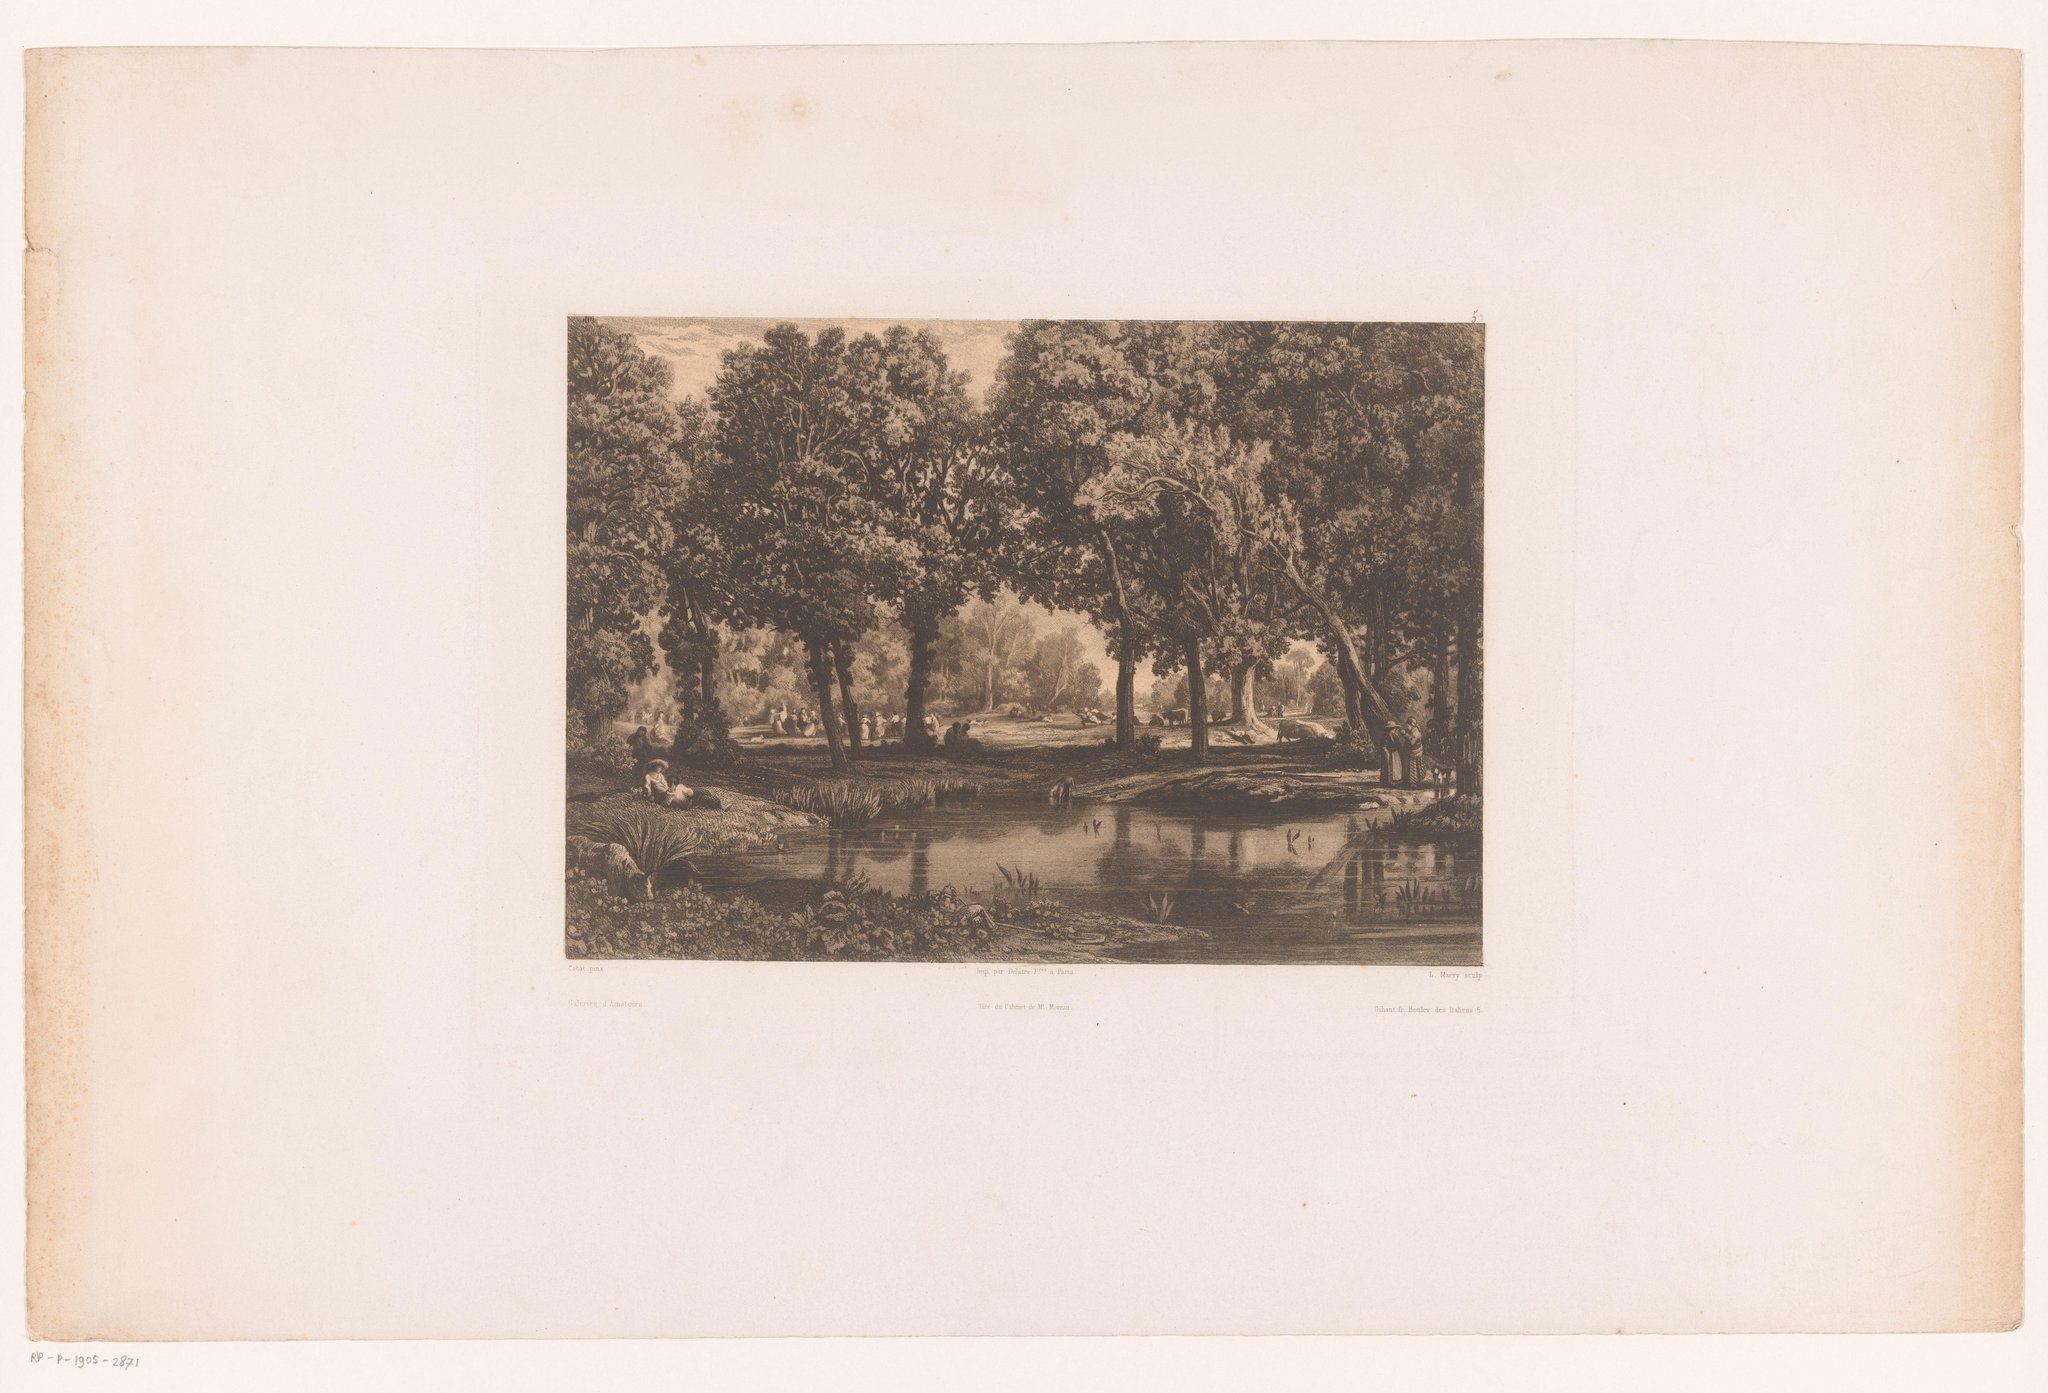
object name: print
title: Landschap met vijver en dansende figuren op de achtergrond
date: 1825-1850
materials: paper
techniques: etching, roulette, soft ground etching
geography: paris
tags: group dancing, pond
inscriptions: collector's mark: Lugt 2228, number: ‘5’